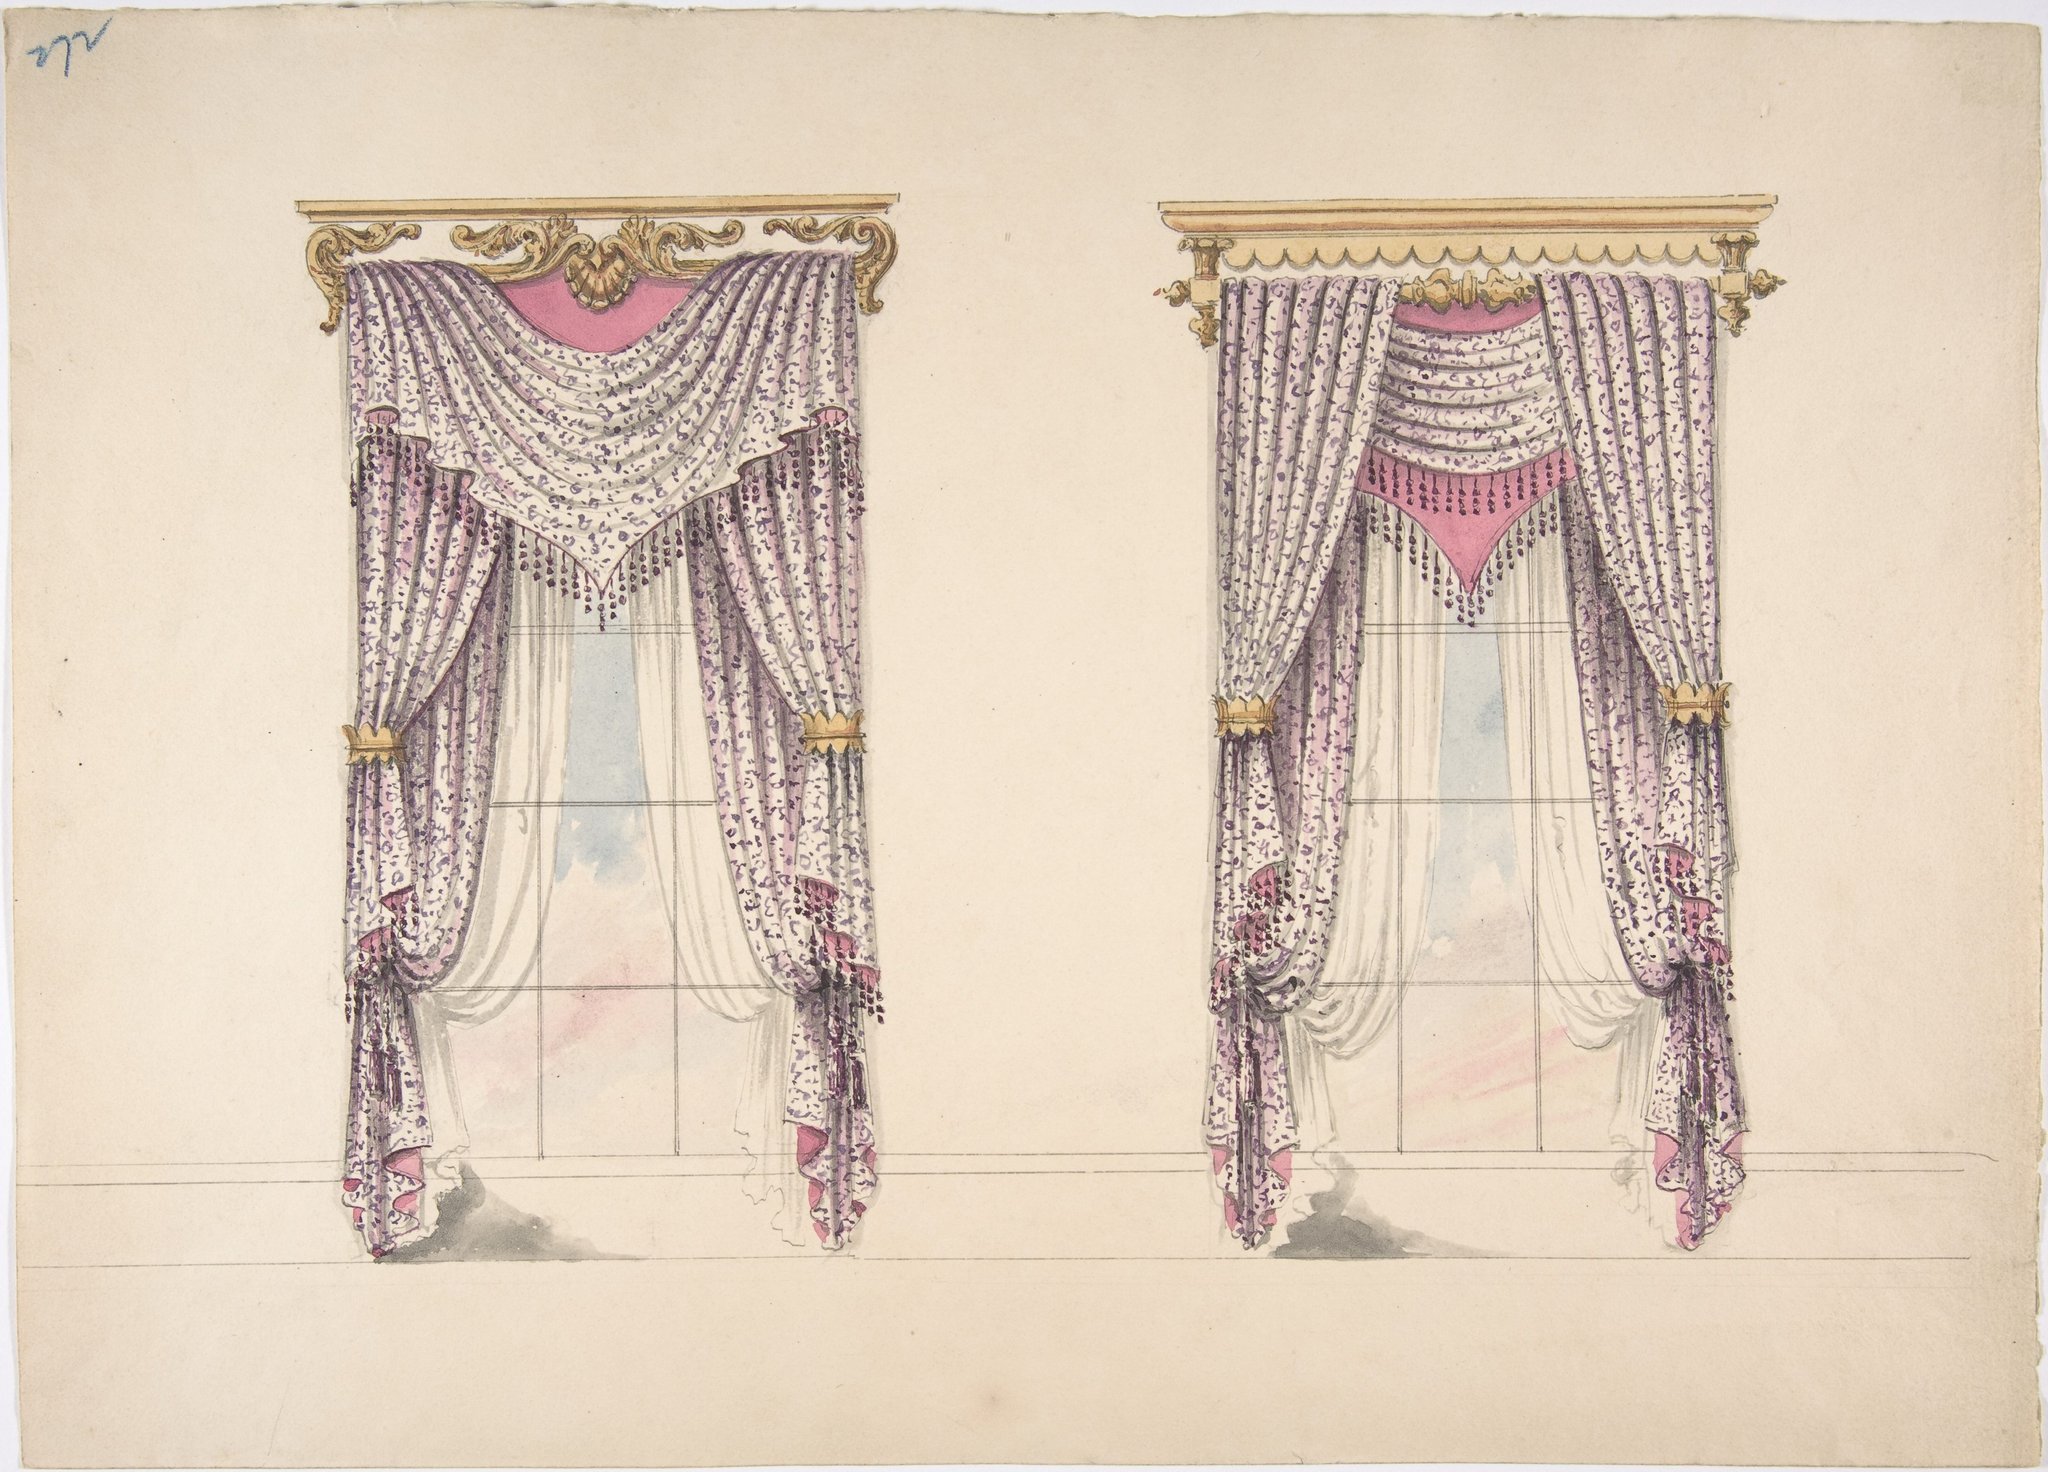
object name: drawing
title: Design for Curtains with Purple, White and Mink Fabric, Purple Fringes and Gold and White Pediments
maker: anonymous, british, 19th century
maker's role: artist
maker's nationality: british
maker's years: 1800-1900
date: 1801-1833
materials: graphite, ink, watercolor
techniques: brush, pen, wash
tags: curtains